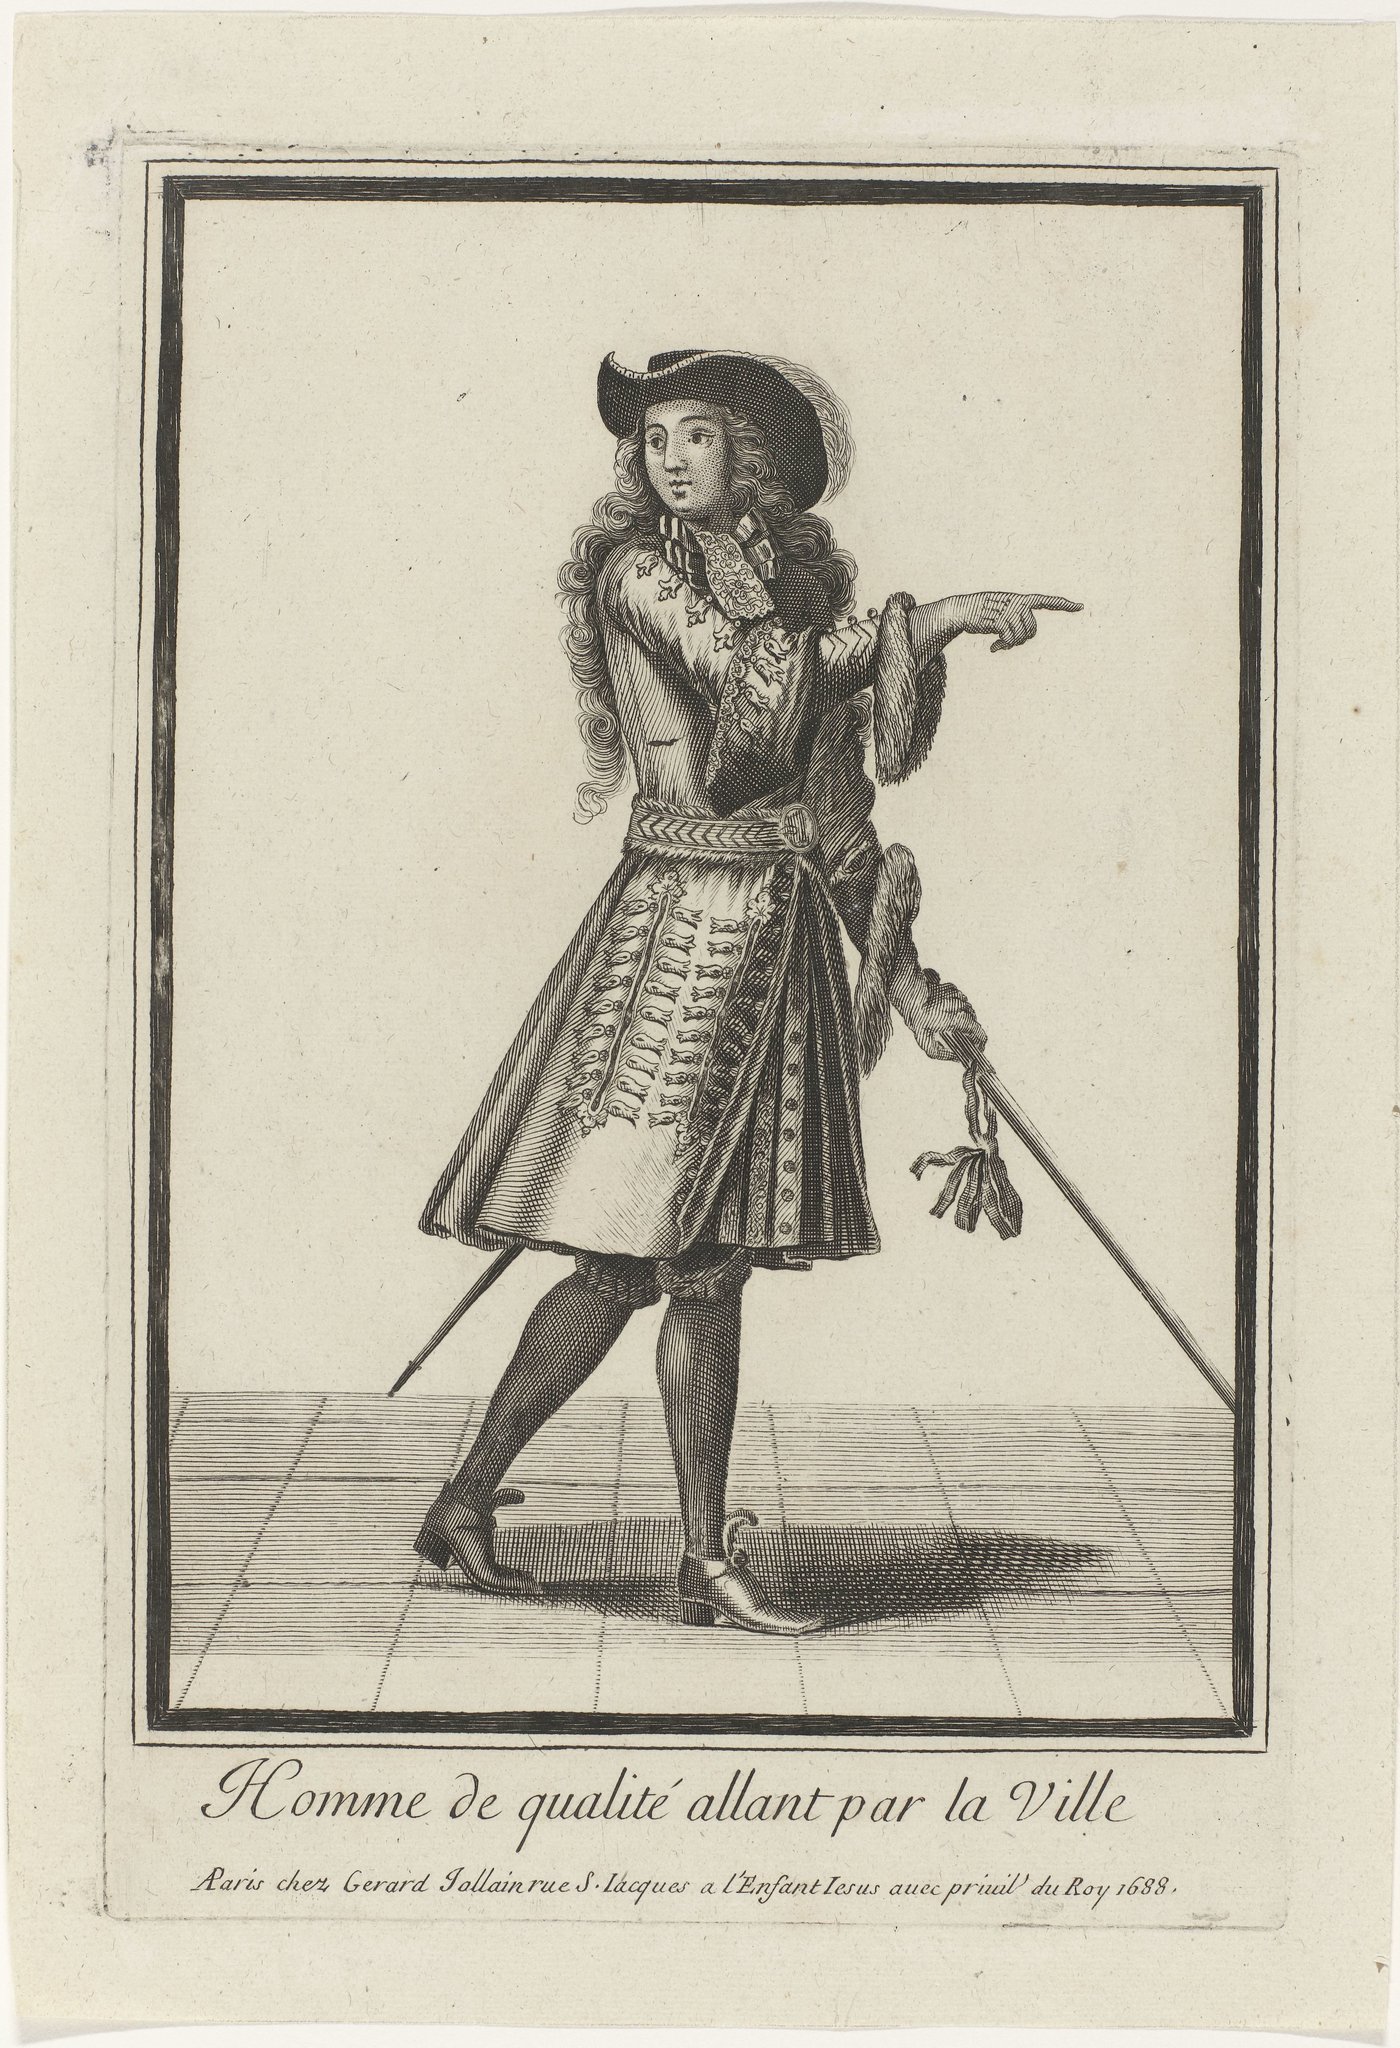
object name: costume print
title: Vooraanstaande jongeman, lopend in de stad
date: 1688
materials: paper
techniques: engraving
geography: paris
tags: clothing for the upper part of the body (vest) (+ men's clothes), neck-gear ~ clothing (cravat) (+ men's clothes), belt, girdle, waistband (+ men's clothes), hacking and thrusting weapons, styles of hairdress (allonge), coat (justaucorps) (+ men's clothes), head-gear: hat (+ men's clothes), fashion plates, shoes, sandals (+ men's clothes), wig, gloves, mittens, etc. (+ men's clothes), sleeves (+ men's clothes)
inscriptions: address: ‘AParis chez Gerard Jollain rue St. Jacques a L'Enfant Iesus avec privil du Roy 1688’, title: ‘Homme de qualité allant par la Ville’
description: Jongeman gekleed in een justaucorps, vest (kamizool) en kniebroek. Hoed op het allongekapsel. Schoenen met gespen en hakken. In de linkerhand een wandelstok. Accessoires: een kanten cravate met strikken, handschoenen met bont, sier(?)degen langs de linkerzij. De prent maakt deel uit van een reeks van ca. 20 kostuumprenten, uitgegeven bij Gérard Jollain, Parijs, 1688